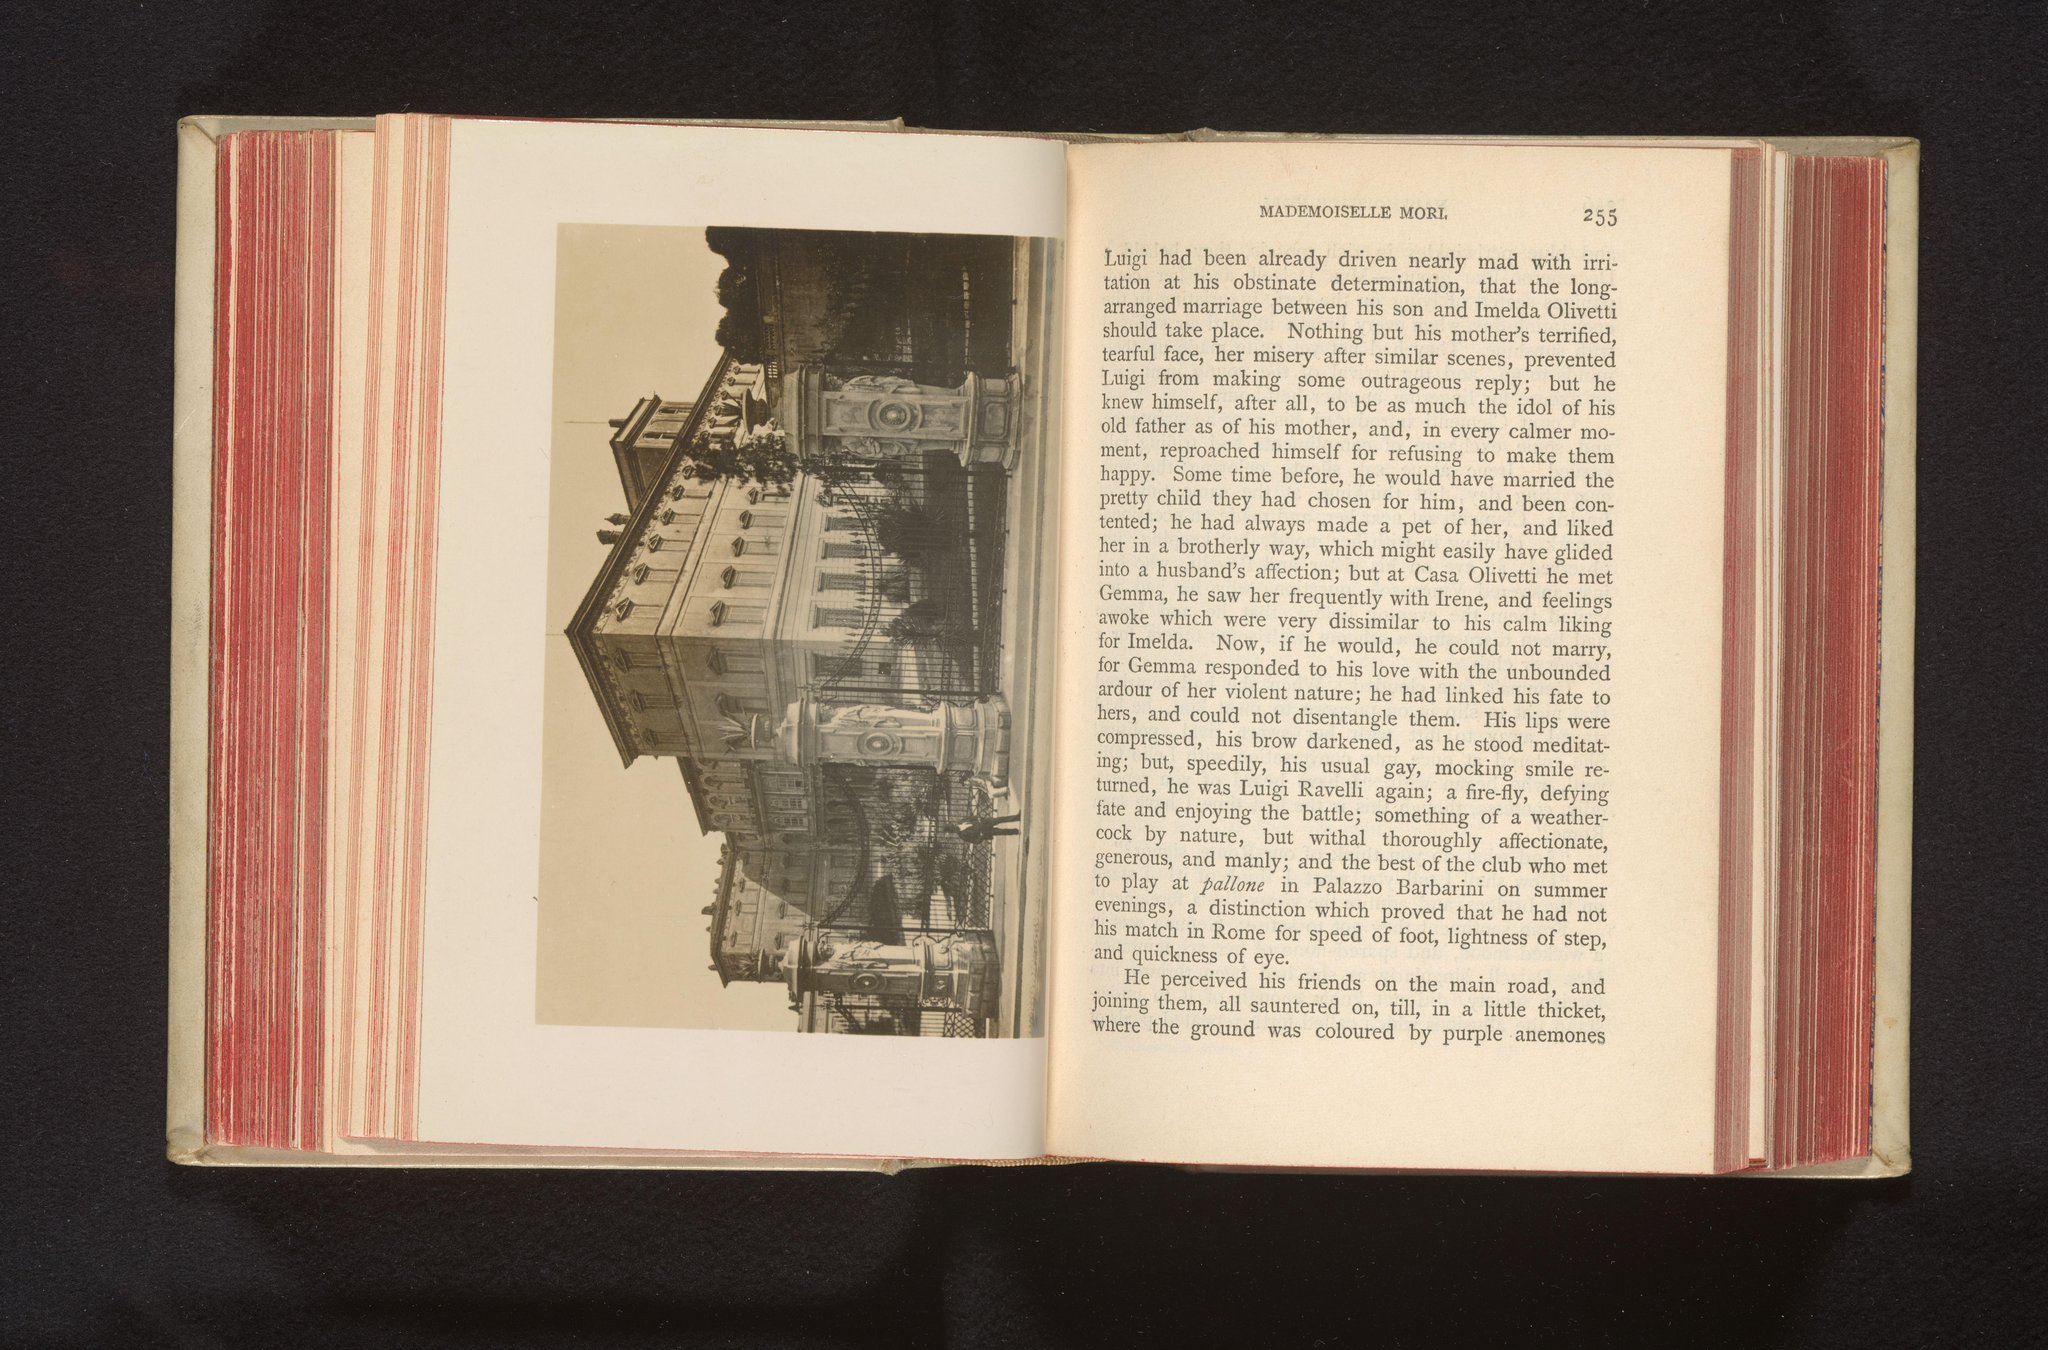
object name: page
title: Exterieur van het Palazzo Barberini te Rome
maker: Anonymous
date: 1852-1862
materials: photographic support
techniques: gelatin silver print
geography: rome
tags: hôtel, i.e. small palace in city, façade (of house or building)